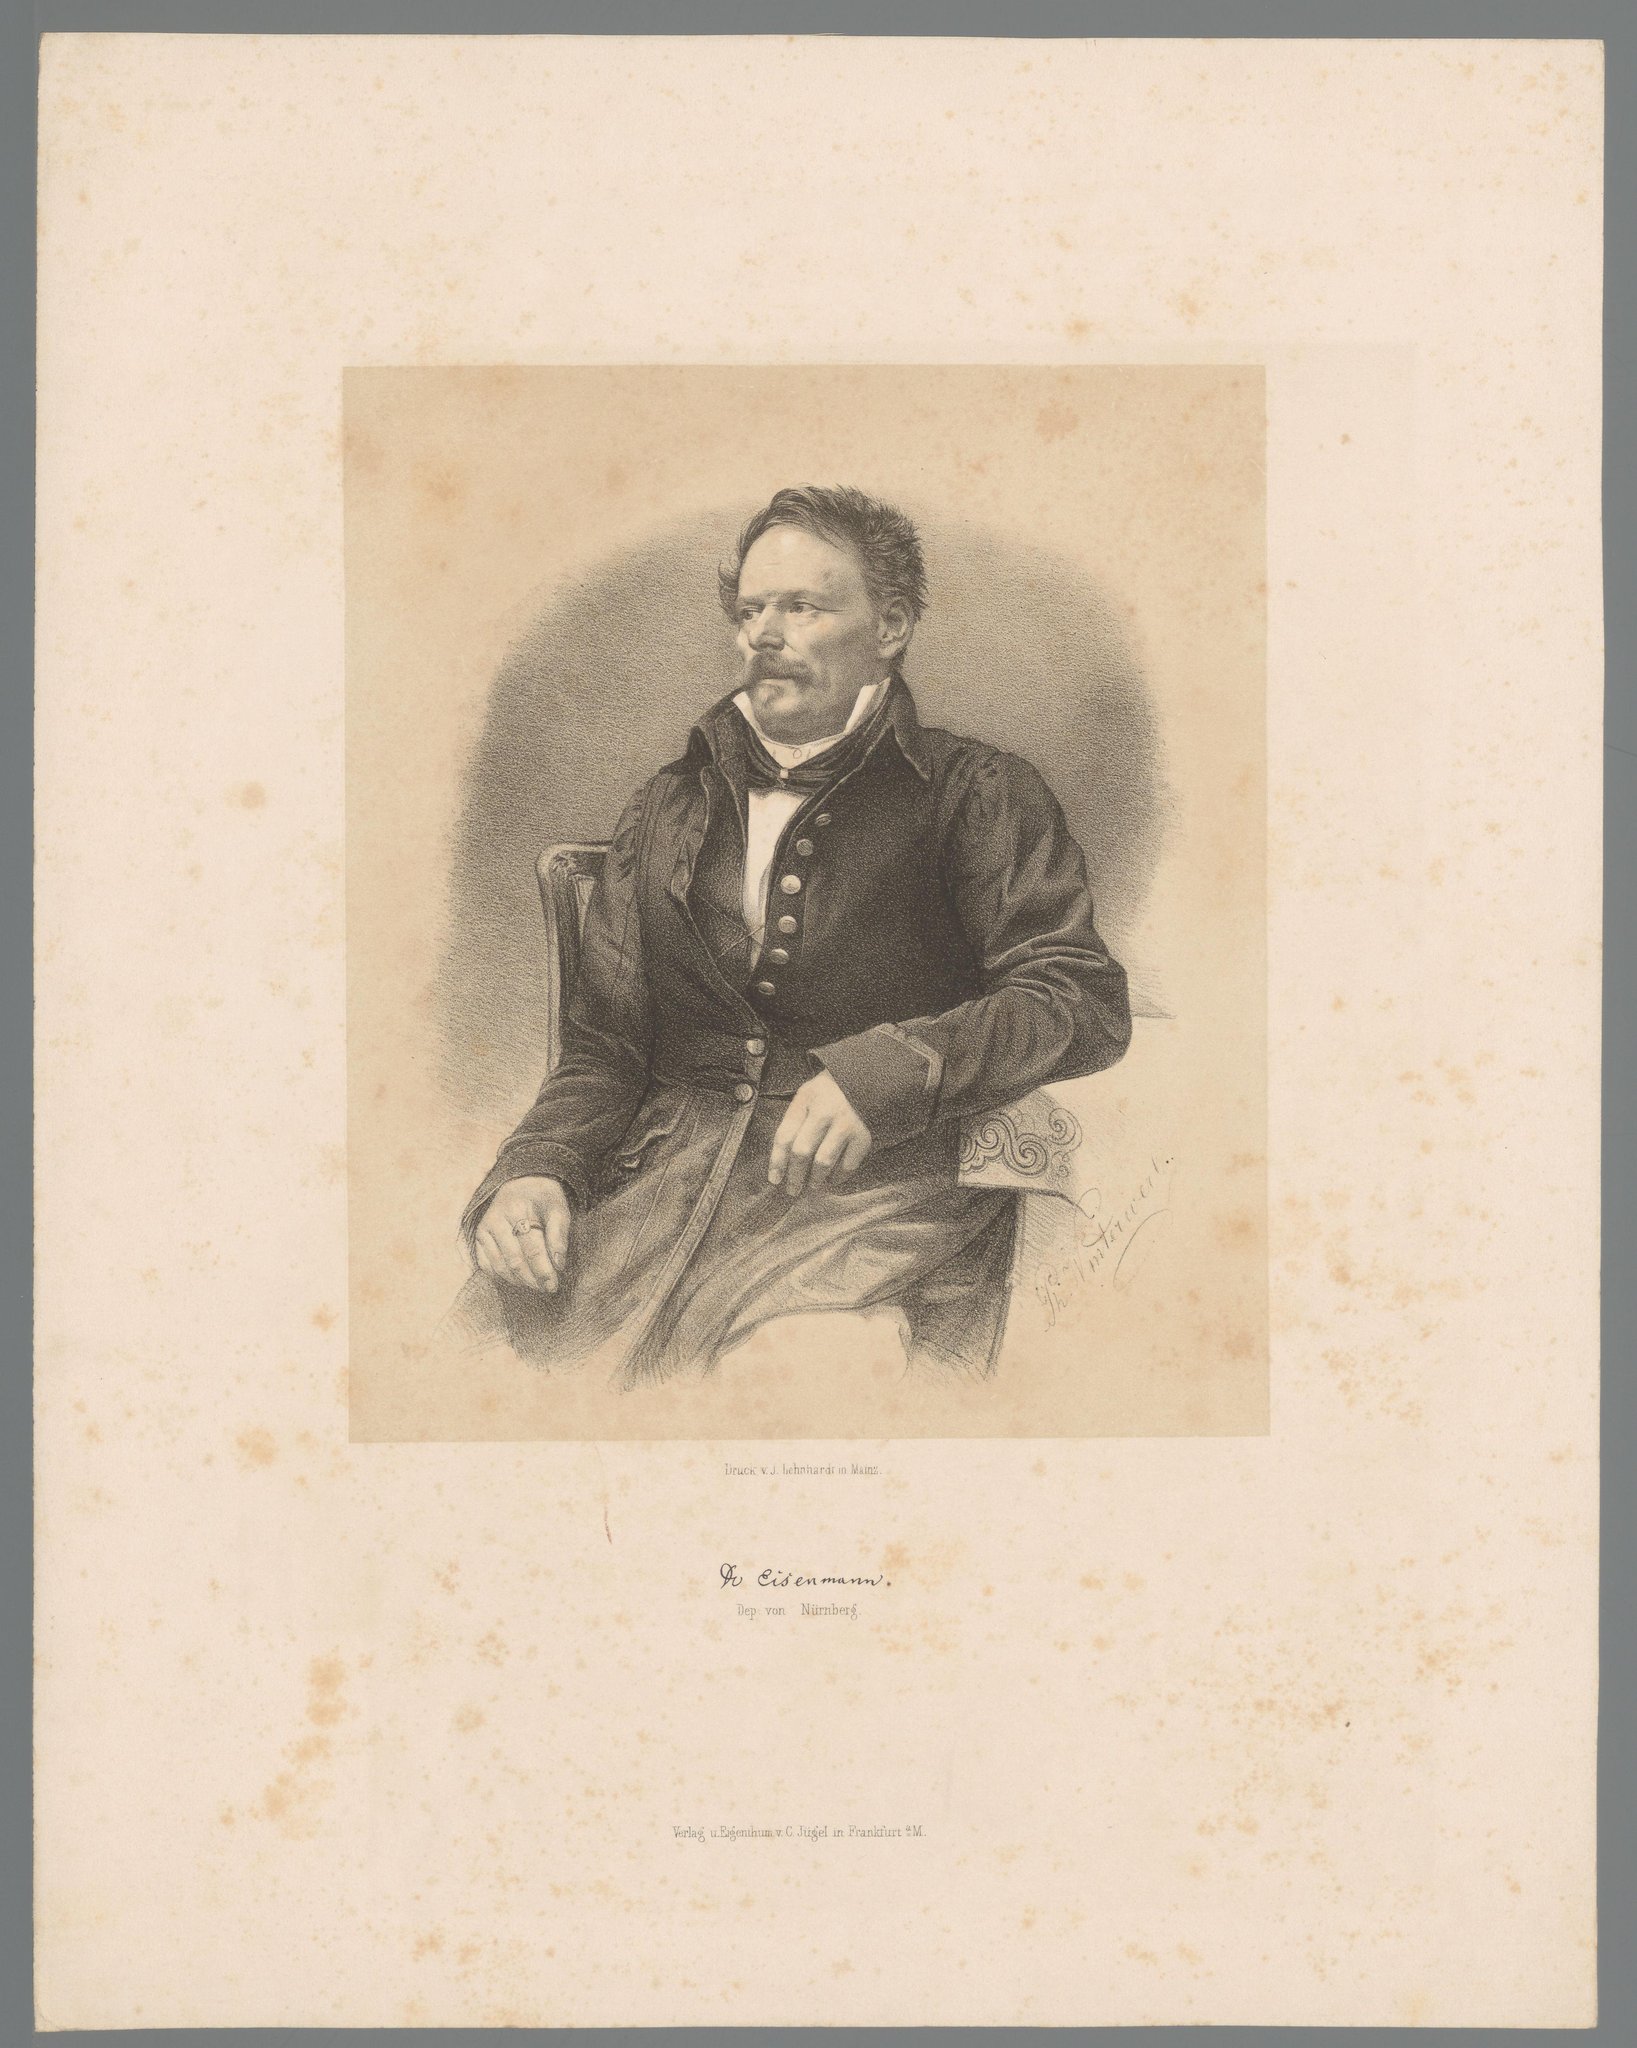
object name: print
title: Portret van Gottfried Eisenmann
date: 1849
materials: paper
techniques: tone lithography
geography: mainz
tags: politician, sitting figure, adult man, historical persons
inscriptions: collector's mark: Lugt 2228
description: Prent behoort waarschijnlijk tot de serie 'Album der deutschen National-Versammlung'. Deze serie bestaat uit circa 54 portretten die onder andere zijn vervaardigd door Philipp Winterwerb en Heinrich Hasselhorst naar foto's van Seib. Deze serie is in 1849 uitgegeven door Carl Christian Jügel.